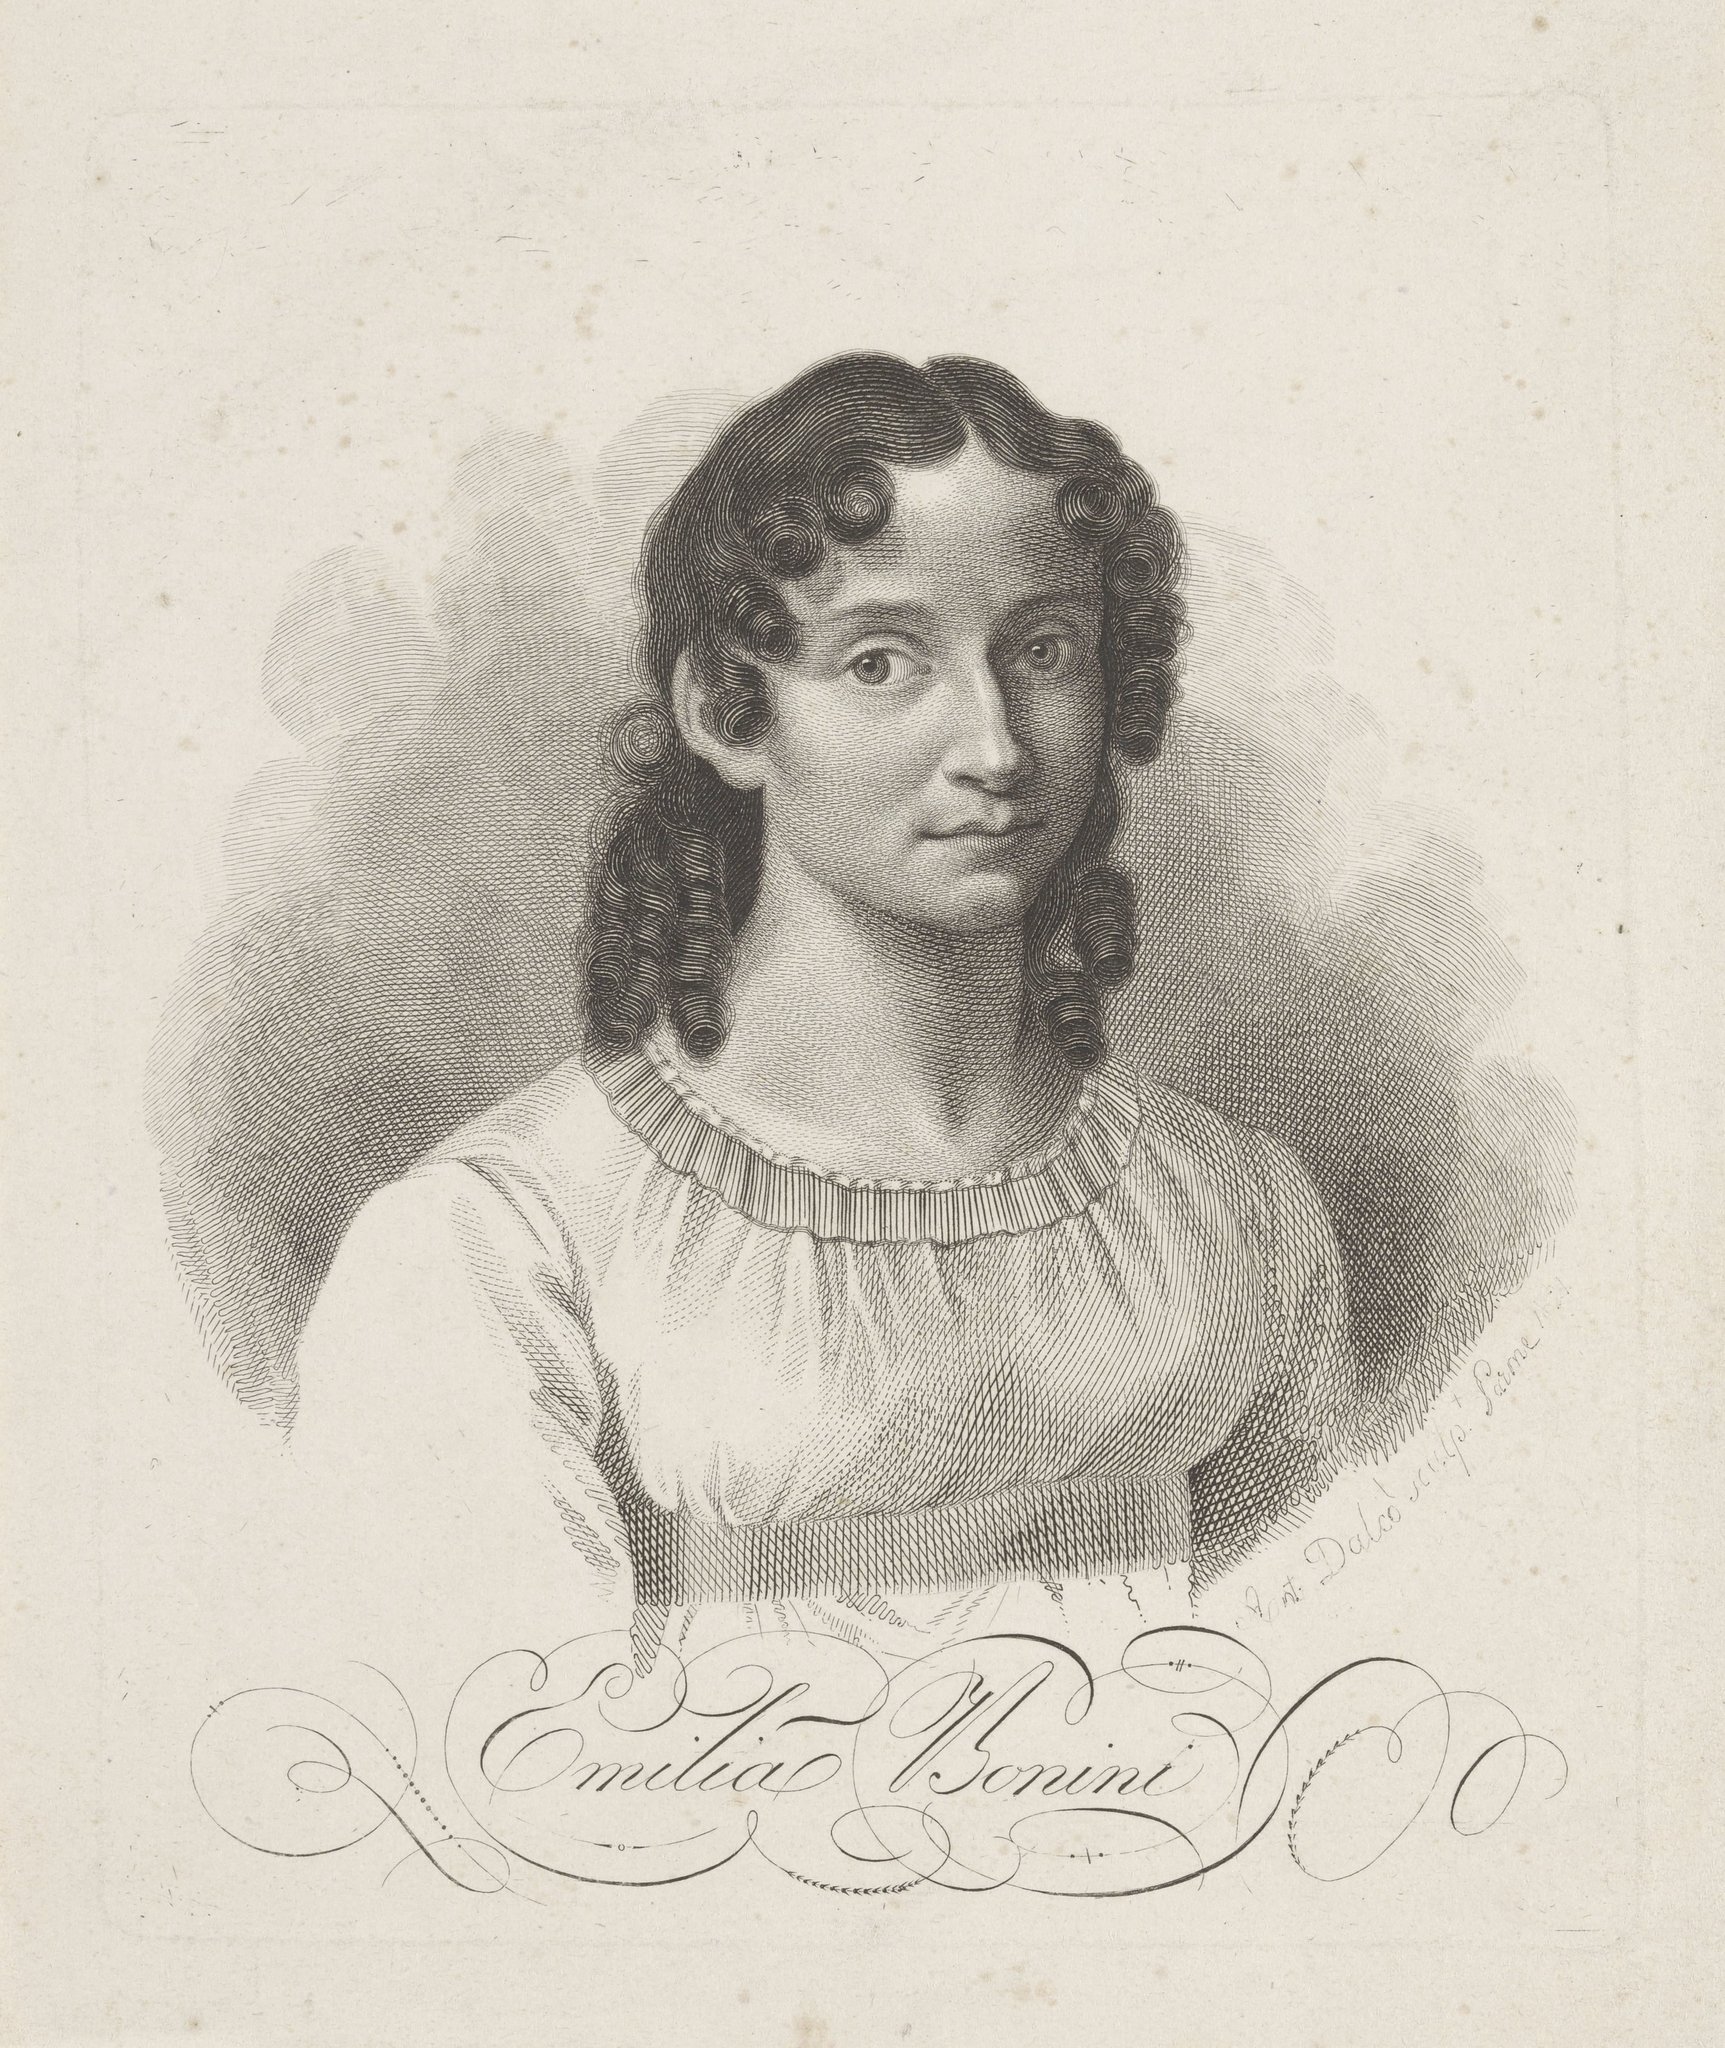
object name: print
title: Portret van Emilia Bonini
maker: antonio dalcò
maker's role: print maker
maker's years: 1802-1888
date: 1821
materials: paper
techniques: engraving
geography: parma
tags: historical persons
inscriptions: collector's mark: Lugt 2228